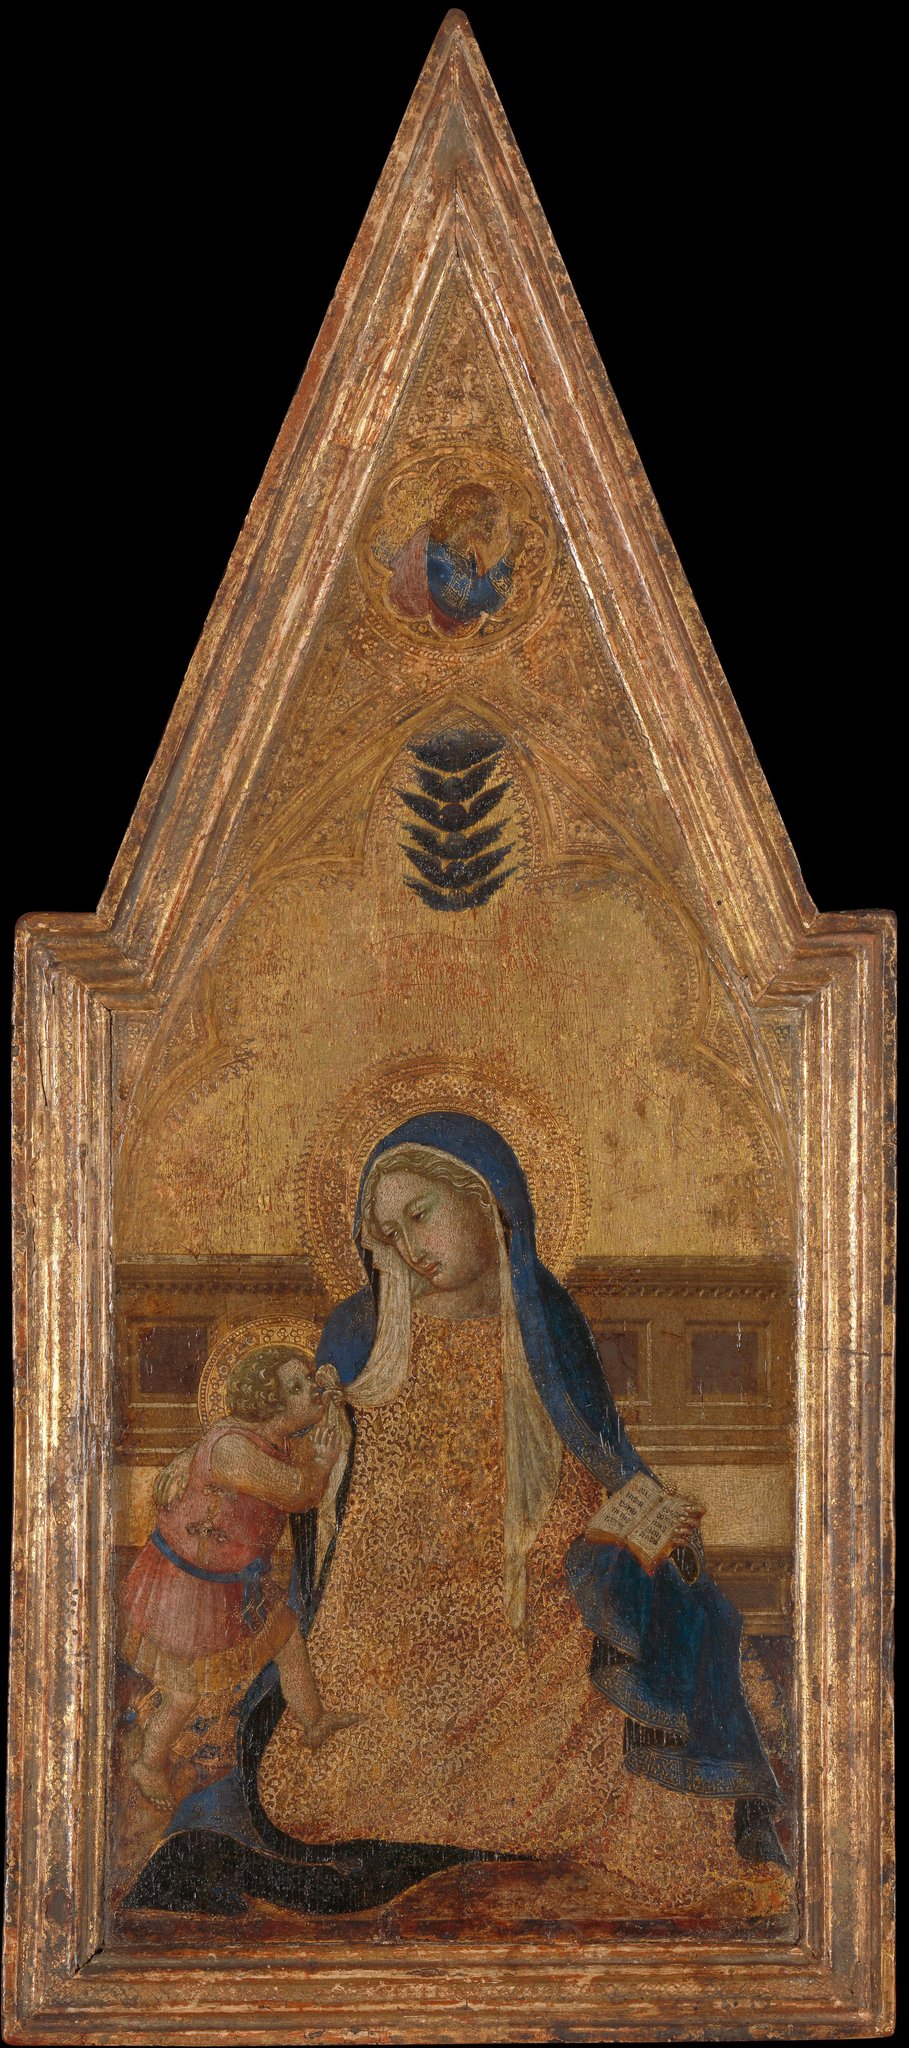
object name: painting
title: Madonna of Humility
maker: bartolommeo bulgarini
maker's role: painter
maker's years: 1345-1378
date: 1353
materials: wood, paint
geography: siena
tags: cushion, 'madonna dell'umiltà' (usually mary suckling the christ-child while sitting on the ground)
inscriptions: inscription: ‘DEUS IN A[D]IUTORIUM DOMIN[E] AD A[D]IUVANDUM’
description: Guild regulations in Siena were less strict than in Florence, so artists there had more scope for innova-tion. The ‘Madonna of Humility’ (Madonna dell’umilità) was a new theme introduced by Sienese artists in the early 14th century. It stressed the Virgin’s humility by showing her seated or kneeling on the floor beside the Christ Child. Here Jesus interrupts her from her reading.